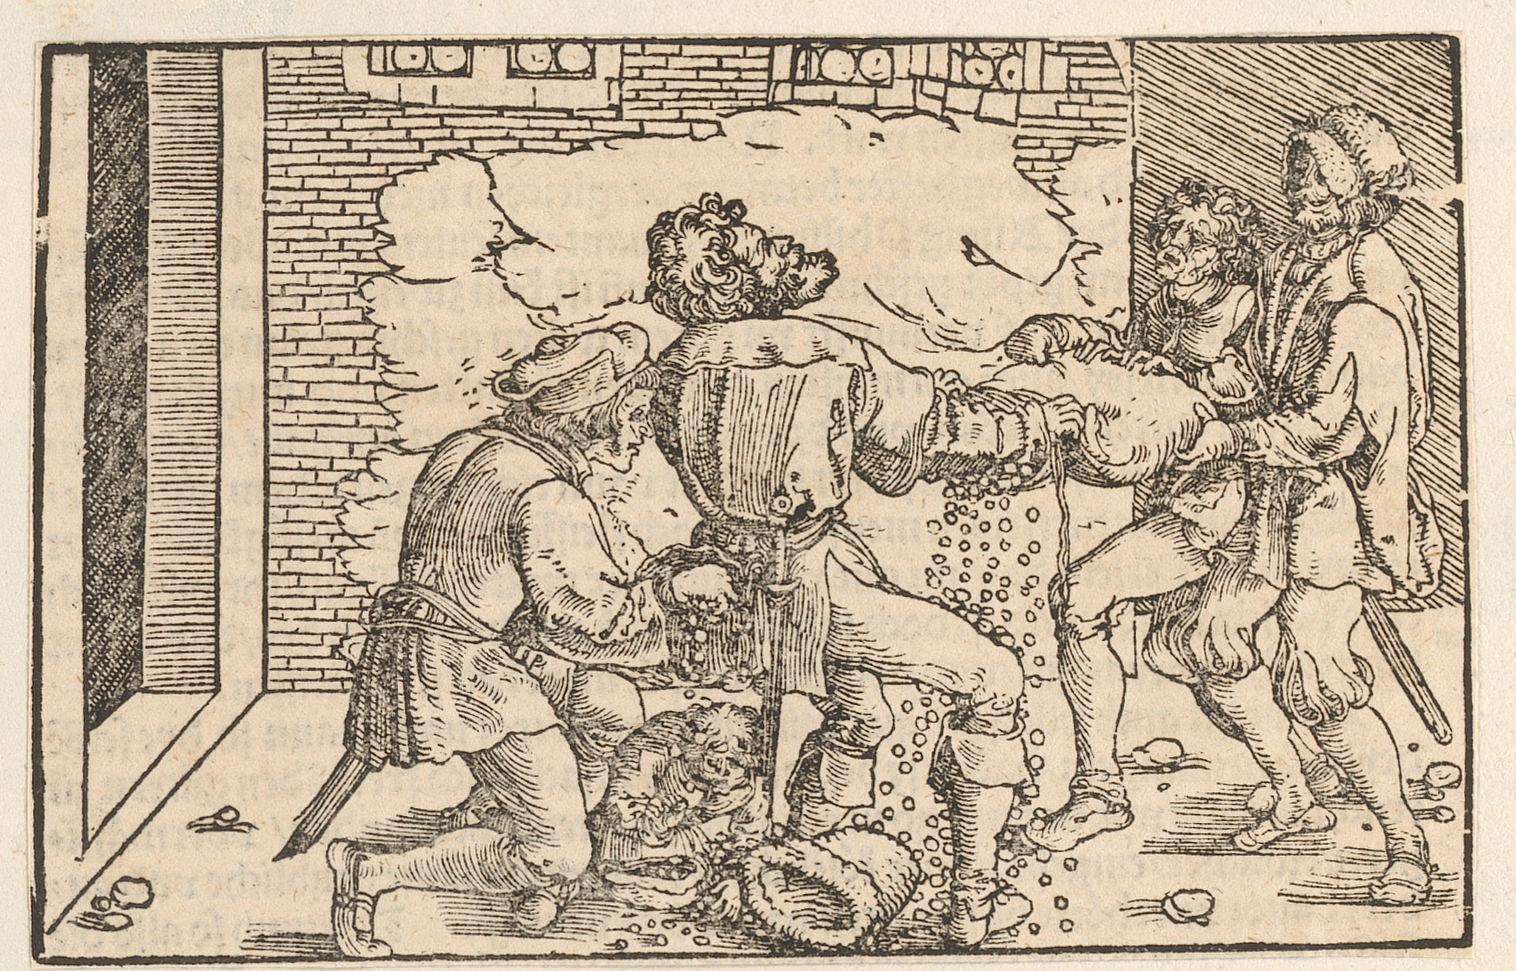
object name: album leaf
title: Man wordt van zijn geld beroofd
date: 1514-1532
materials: paper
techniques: letterpress printing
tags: theft, robbery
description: Deze prent is gebruikt in: Petrarca, Francesco. Von der Artzney bayder Glück, des guten und widerwertigen: unnd weß sich ain yeder inn Gelück und Unglück halten sol (...). Augsburg: Heinrich Steiner, 1532. Deze uitgave is ook bekend onder de titel 'Trostspiegel in Glück und Unglück'. Deze prent is ook gebruikt in: Cicero, Marcus Tulius. Officia M.T.C. Ein Buch so Marcus Tullius Cicero der Römer zu seynem (...). [Vertaald uit het Latijn door] Johann von Schwarzenberg. Augsburg: Heinrich Steiner, 1531.